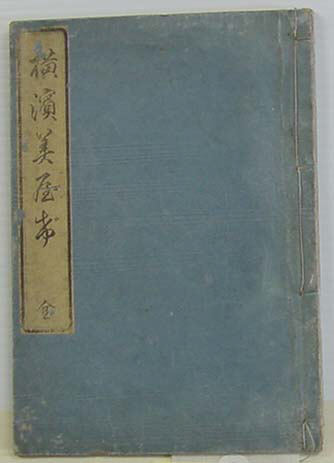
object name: illustrated book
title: Famous Places on the Tōkaidō, the Landscape of Yokohama (Tōkaidō meisho no uchi Yokohama fūkei)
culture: japanese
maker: utagawa (gountei) sadahide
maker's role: artist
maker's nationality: japanese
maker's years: 1807-1873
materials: ink, paper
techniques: polychrome, woodblock print